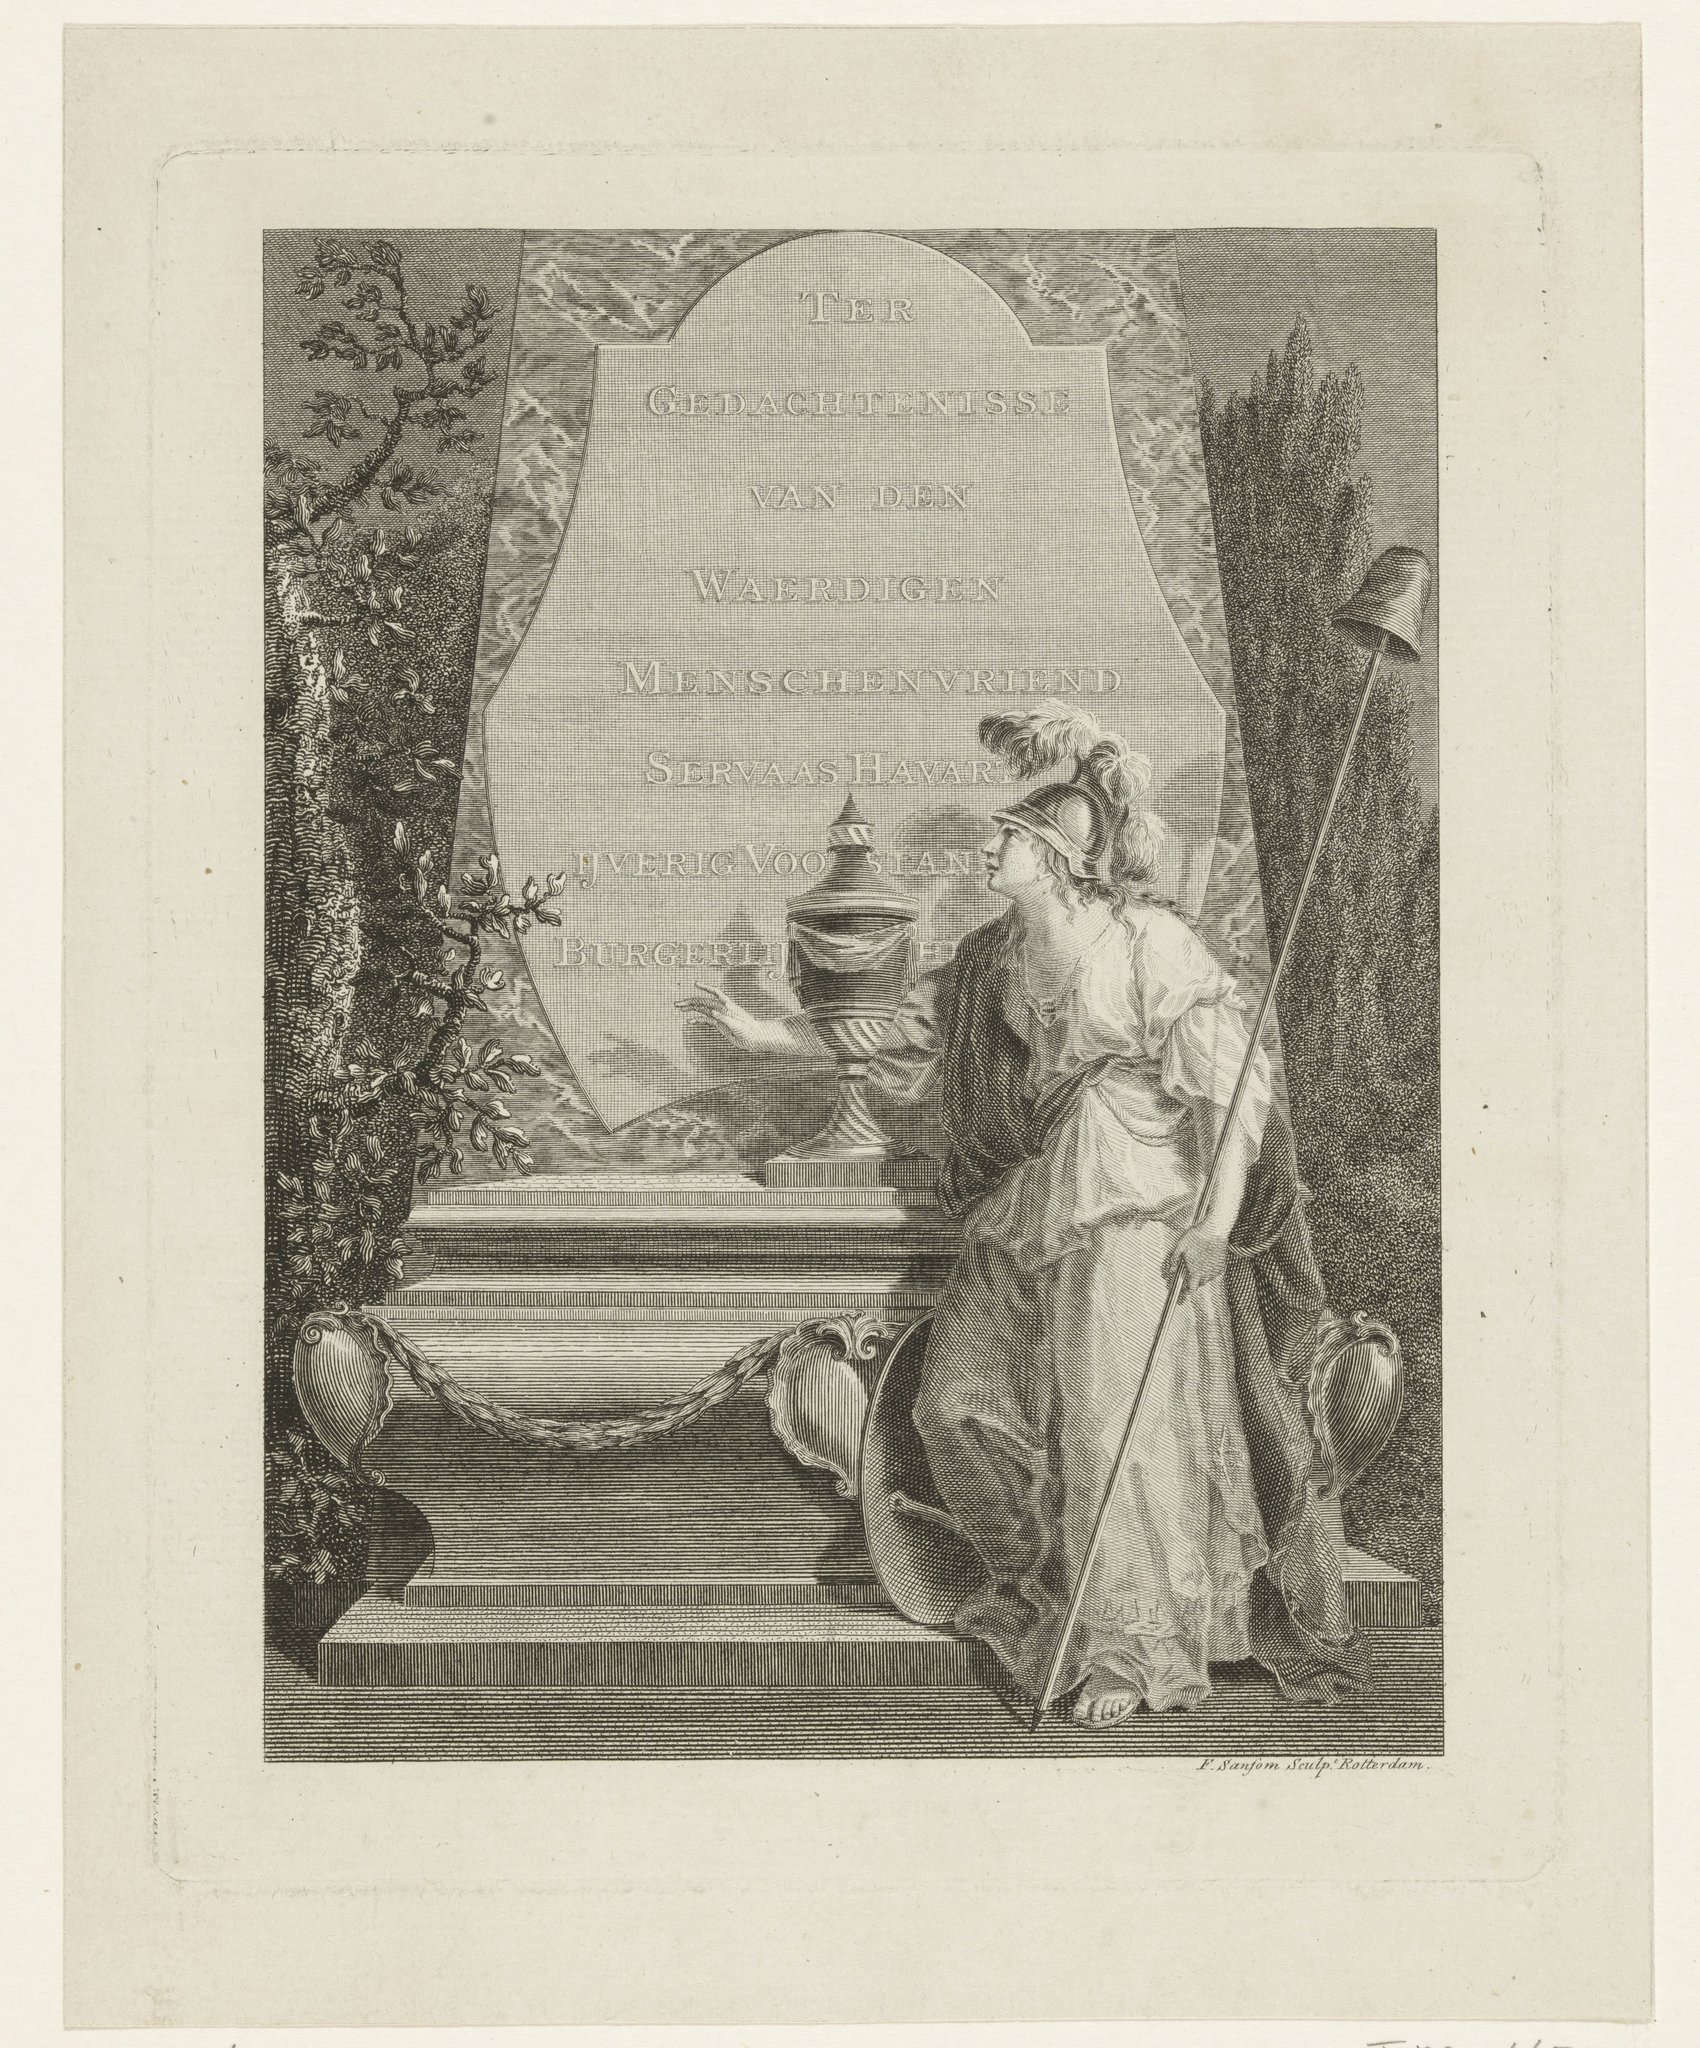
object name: print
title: Monument ter nagedachtenis van Servaas Havart, 1785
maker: franciscus sansom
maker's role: print maker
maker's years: -1788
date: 1785-1786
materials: paper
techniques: engraving, etching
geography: rotterdam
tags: grave-building, monumental tomb, freedom, liberty; 'libertà' (ripa) (+ abstract concept represented by female figure), rotterdam, patriots (1780-1795)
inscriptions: collector's mark: Lugt 2166, collector's mark: Lugt 2760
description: Allegorisch monument ter nagedachtenis van Servaas Havart, een ijverig Rotterdamse patriot, overleden 17 december 1785. De maagd van de Nederlandse Vrijheid bij het graf met urn en grafschrift.